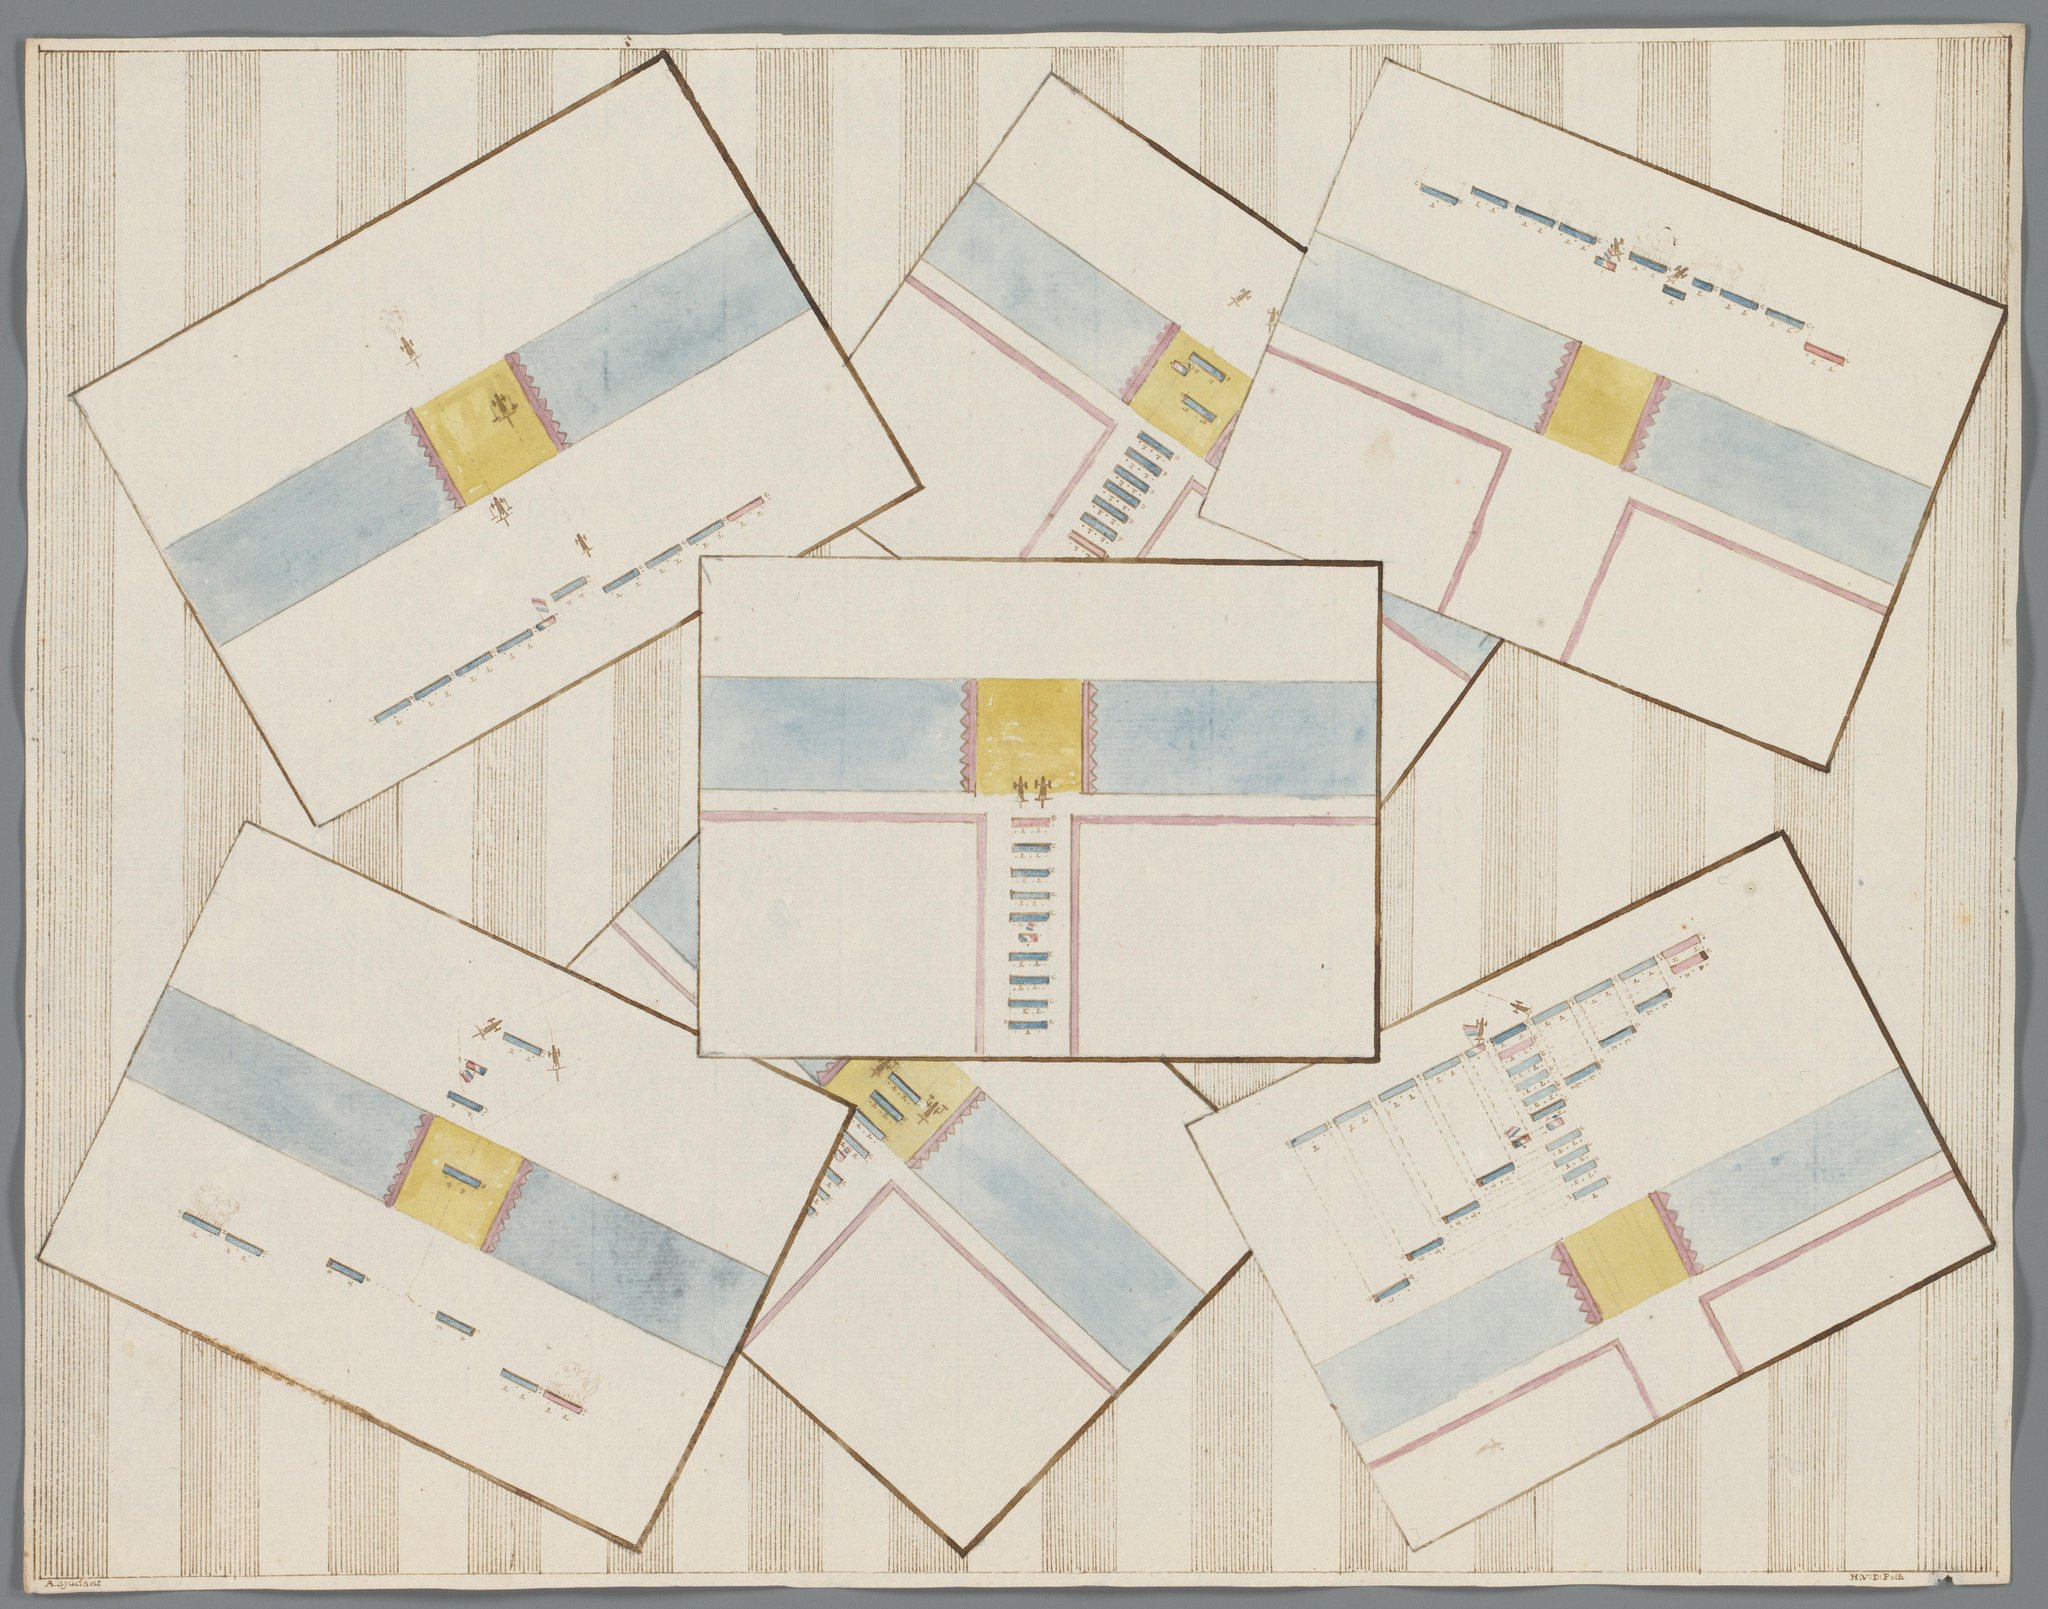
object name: drawing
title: Manoeuvres van de compagnieën, ca. 1799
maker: hendrik van der poth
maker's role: draughtsman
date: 1799-1803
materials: paper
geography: netherlands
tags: manoeuvre ~ military training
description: Blad met zeven kaartjes van verschillende manoeuvres van de zeven compagnieën van het Bataafse bataljon. Ten tijde van de Brits-Russische expeditie in 1799. Onderdeel van een groep van zeventien getekende kaarten.